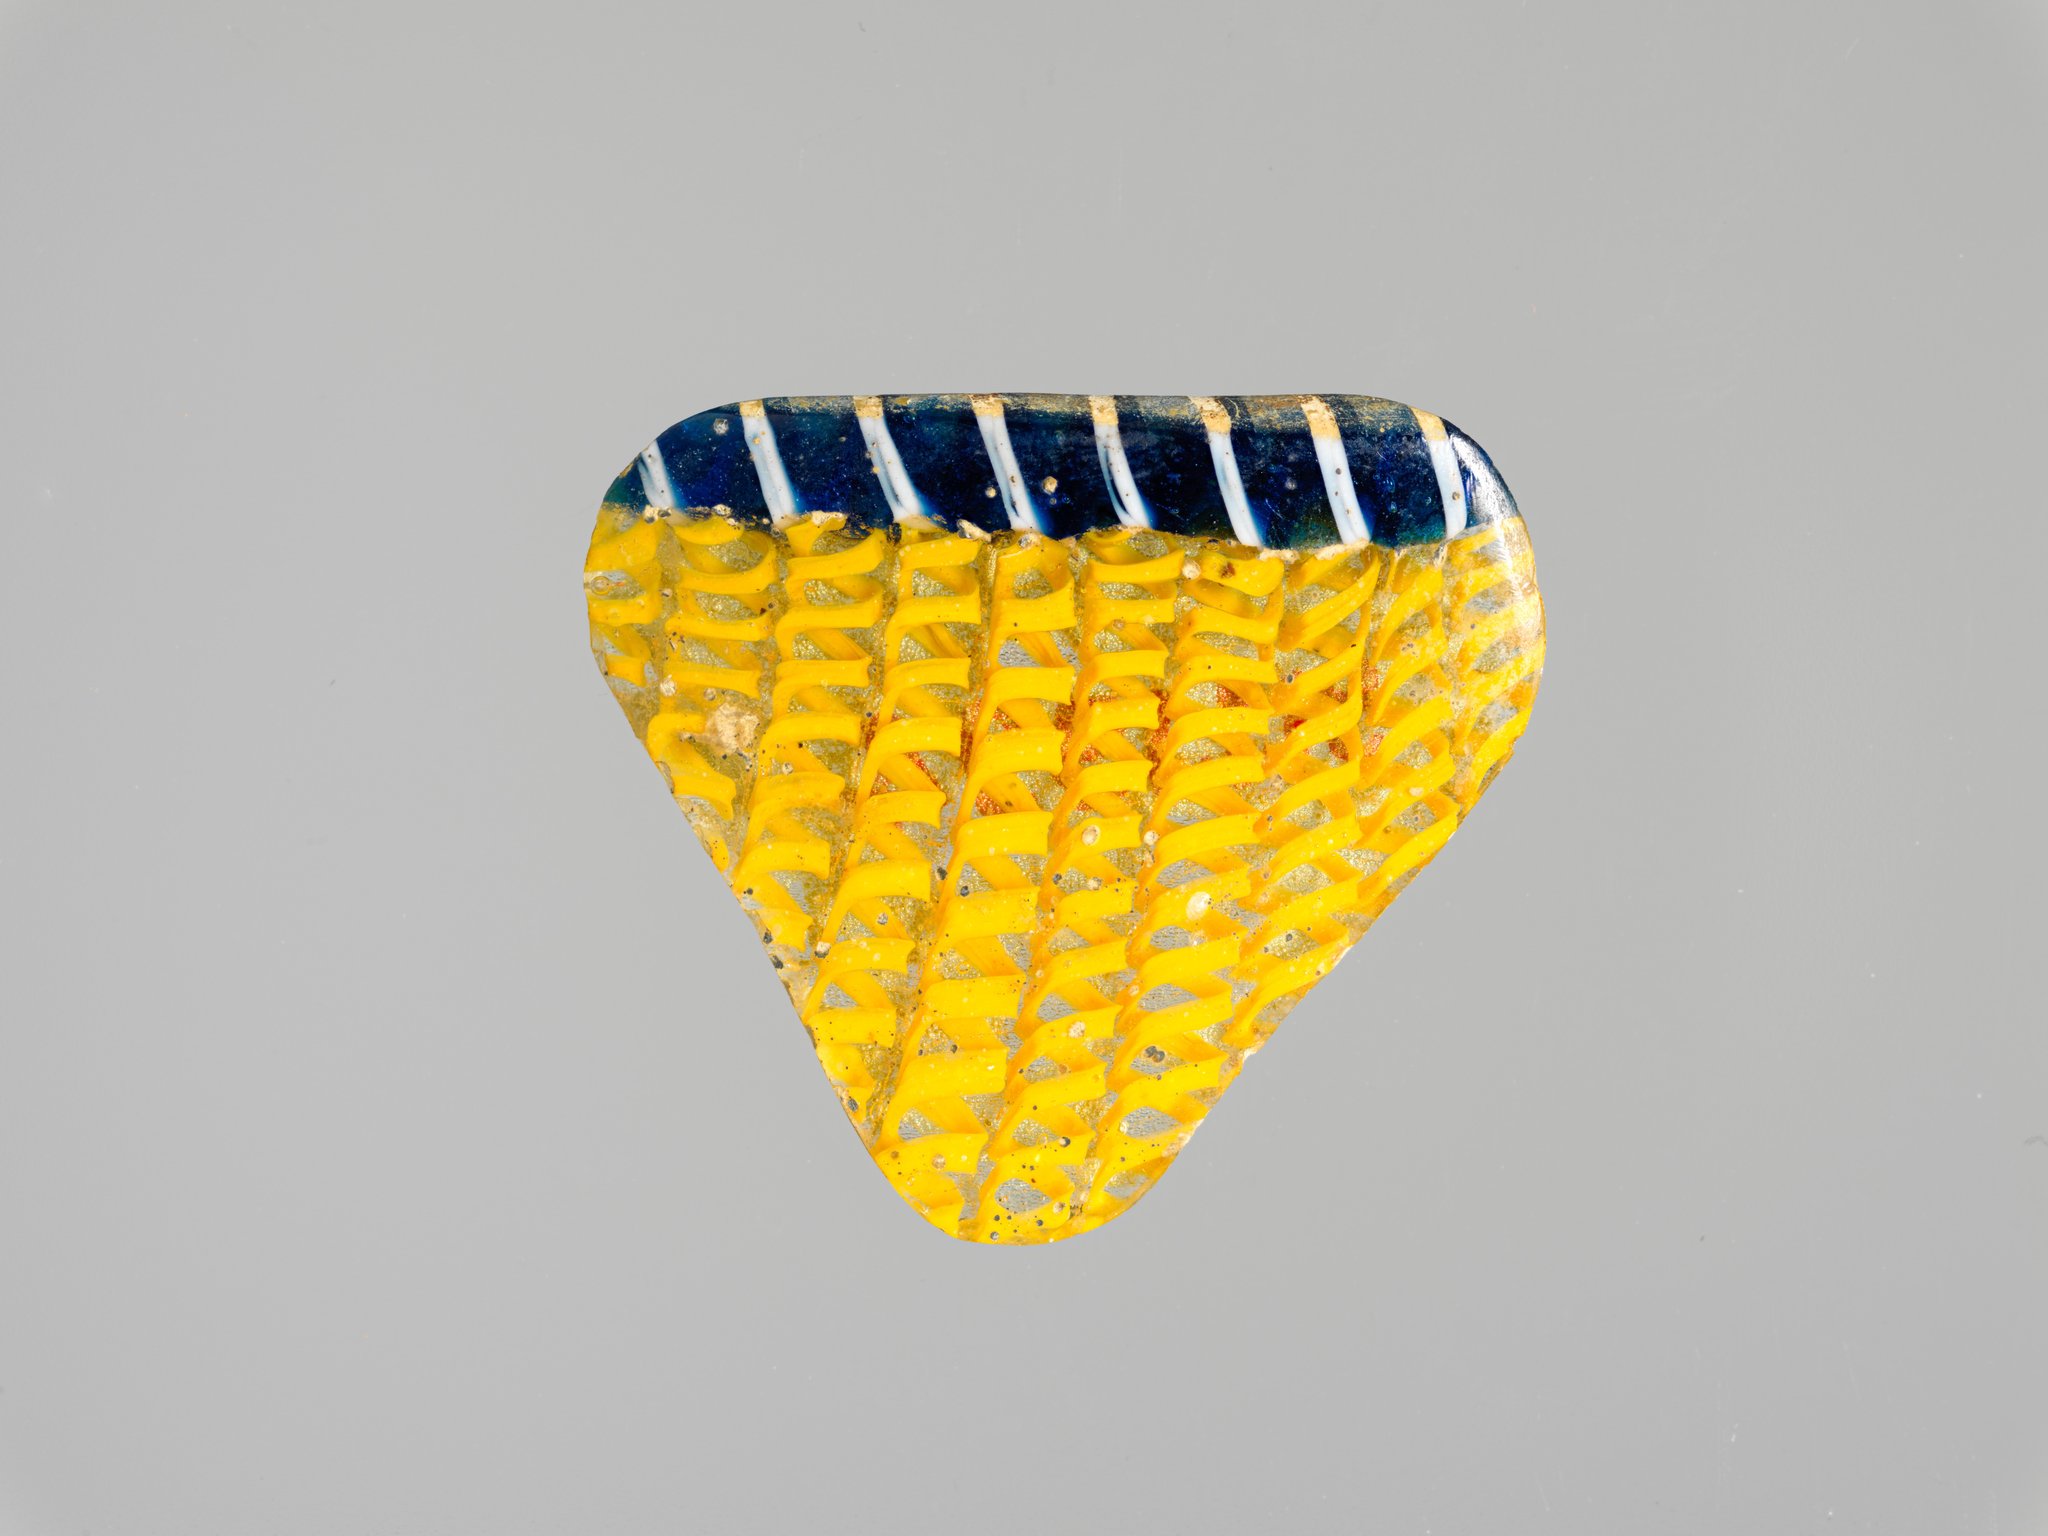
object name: fragment, network mosaic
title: Glass network mosaic fragment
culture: roman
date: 34 BCE-33 CE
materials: glass